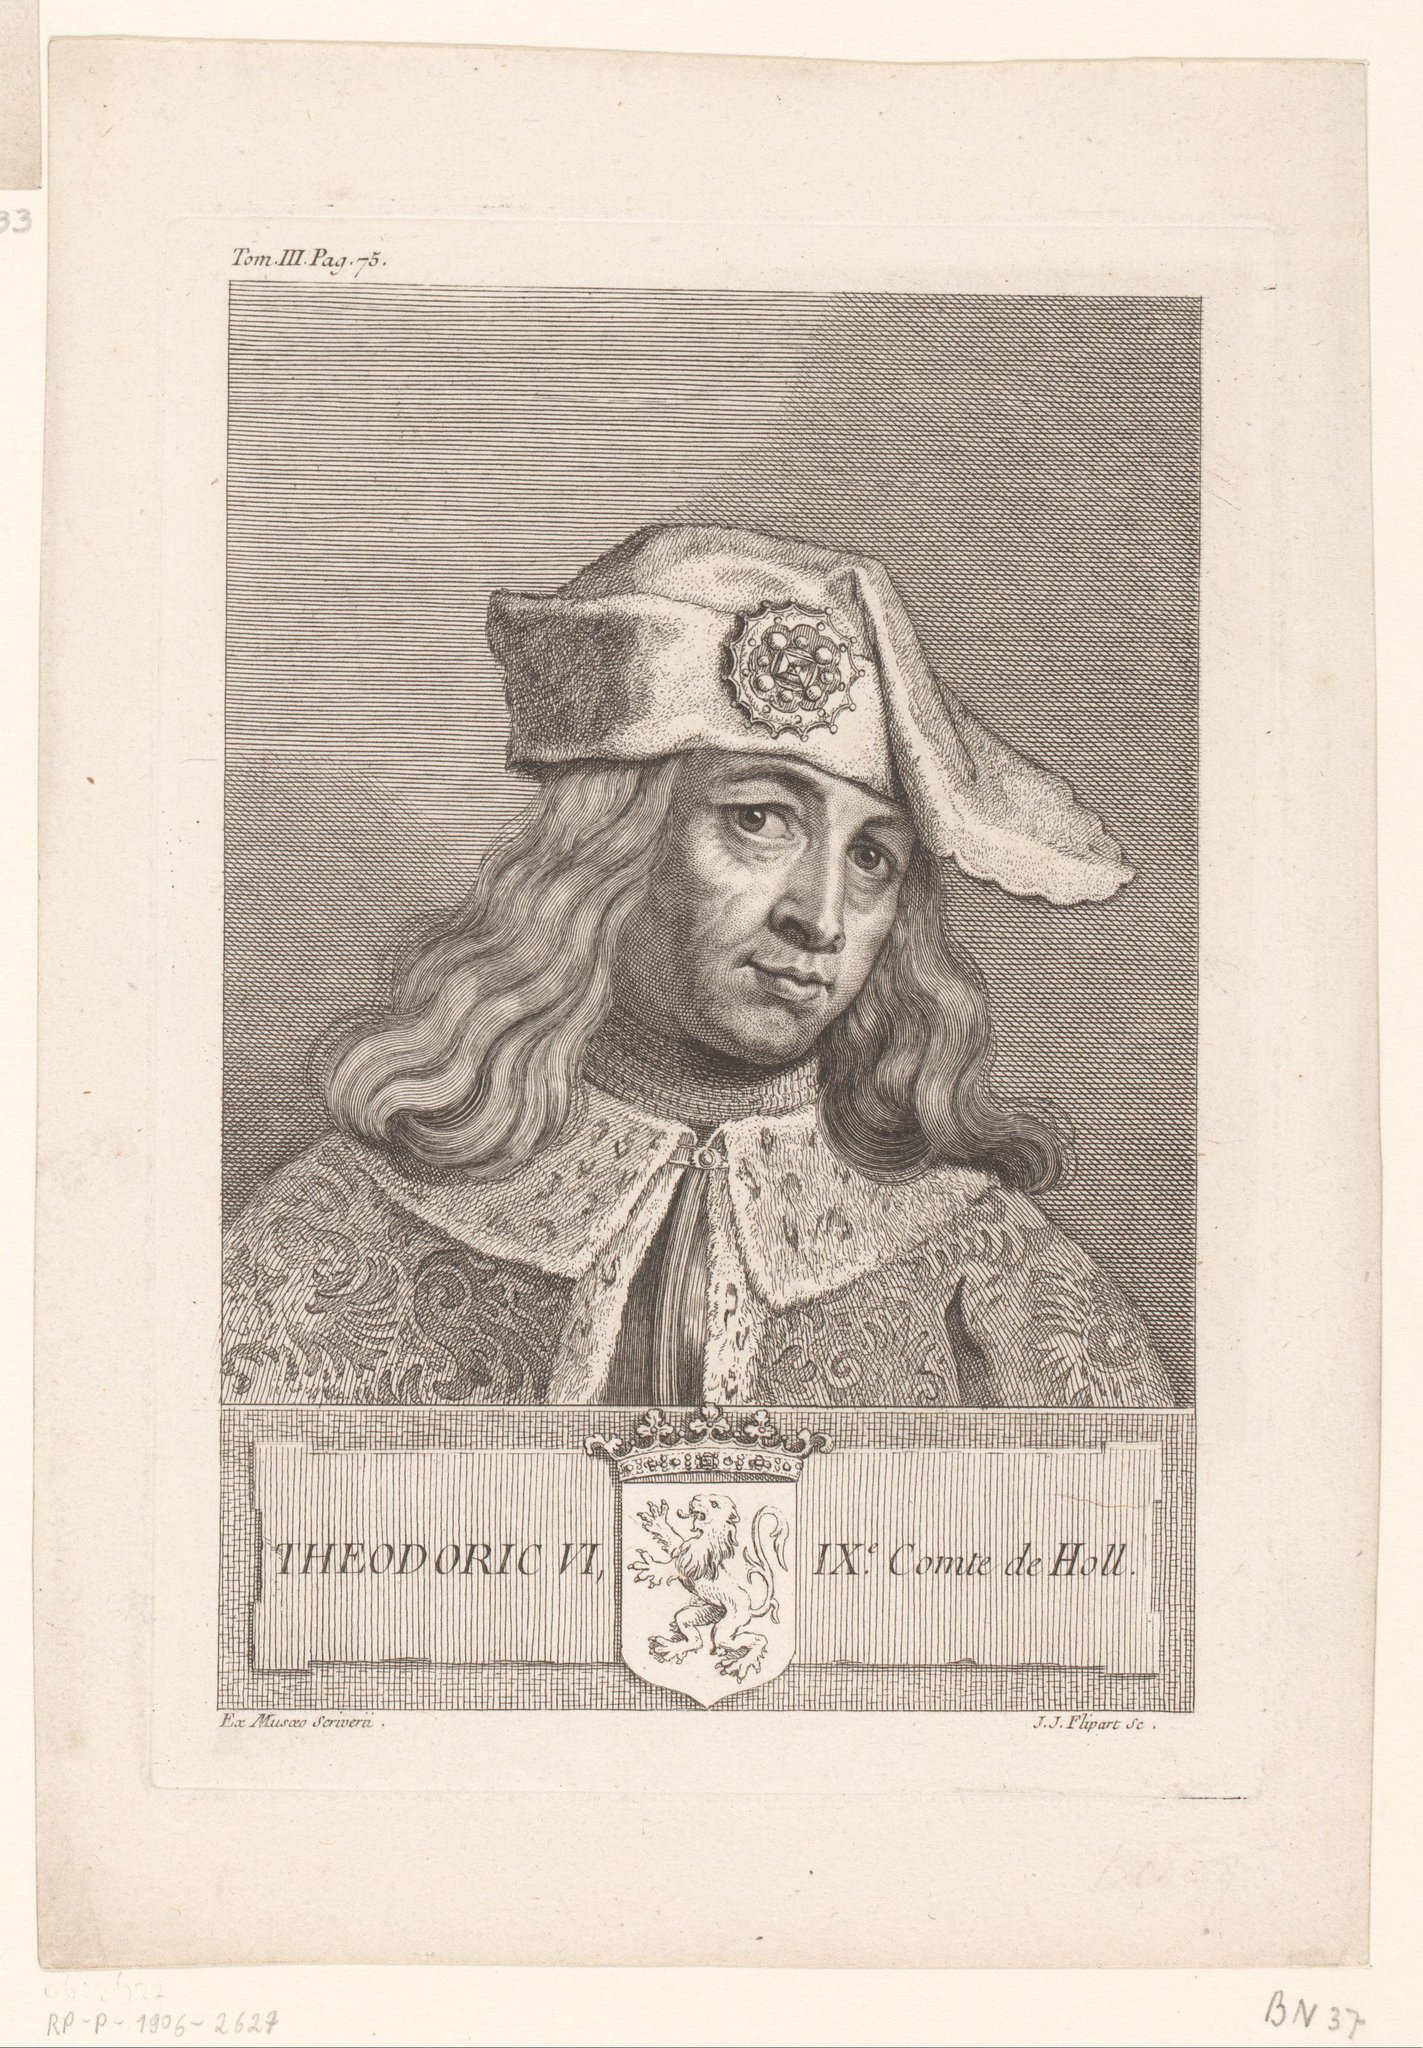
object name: book illustration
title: Portret van Dirk VI van Holland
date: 1757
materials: paper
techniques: engraving, etching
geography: paris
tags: historical persons, ruler, sovereign, armorial bearing, heraldry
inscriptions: collector's mark: Lugt 2228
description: Prent uit: Sellius en Dujardin. Histoire générale des Provinces-Unies. Parijs: Pierre Guillaume Simon, 1957, dl. 3, p. 75.